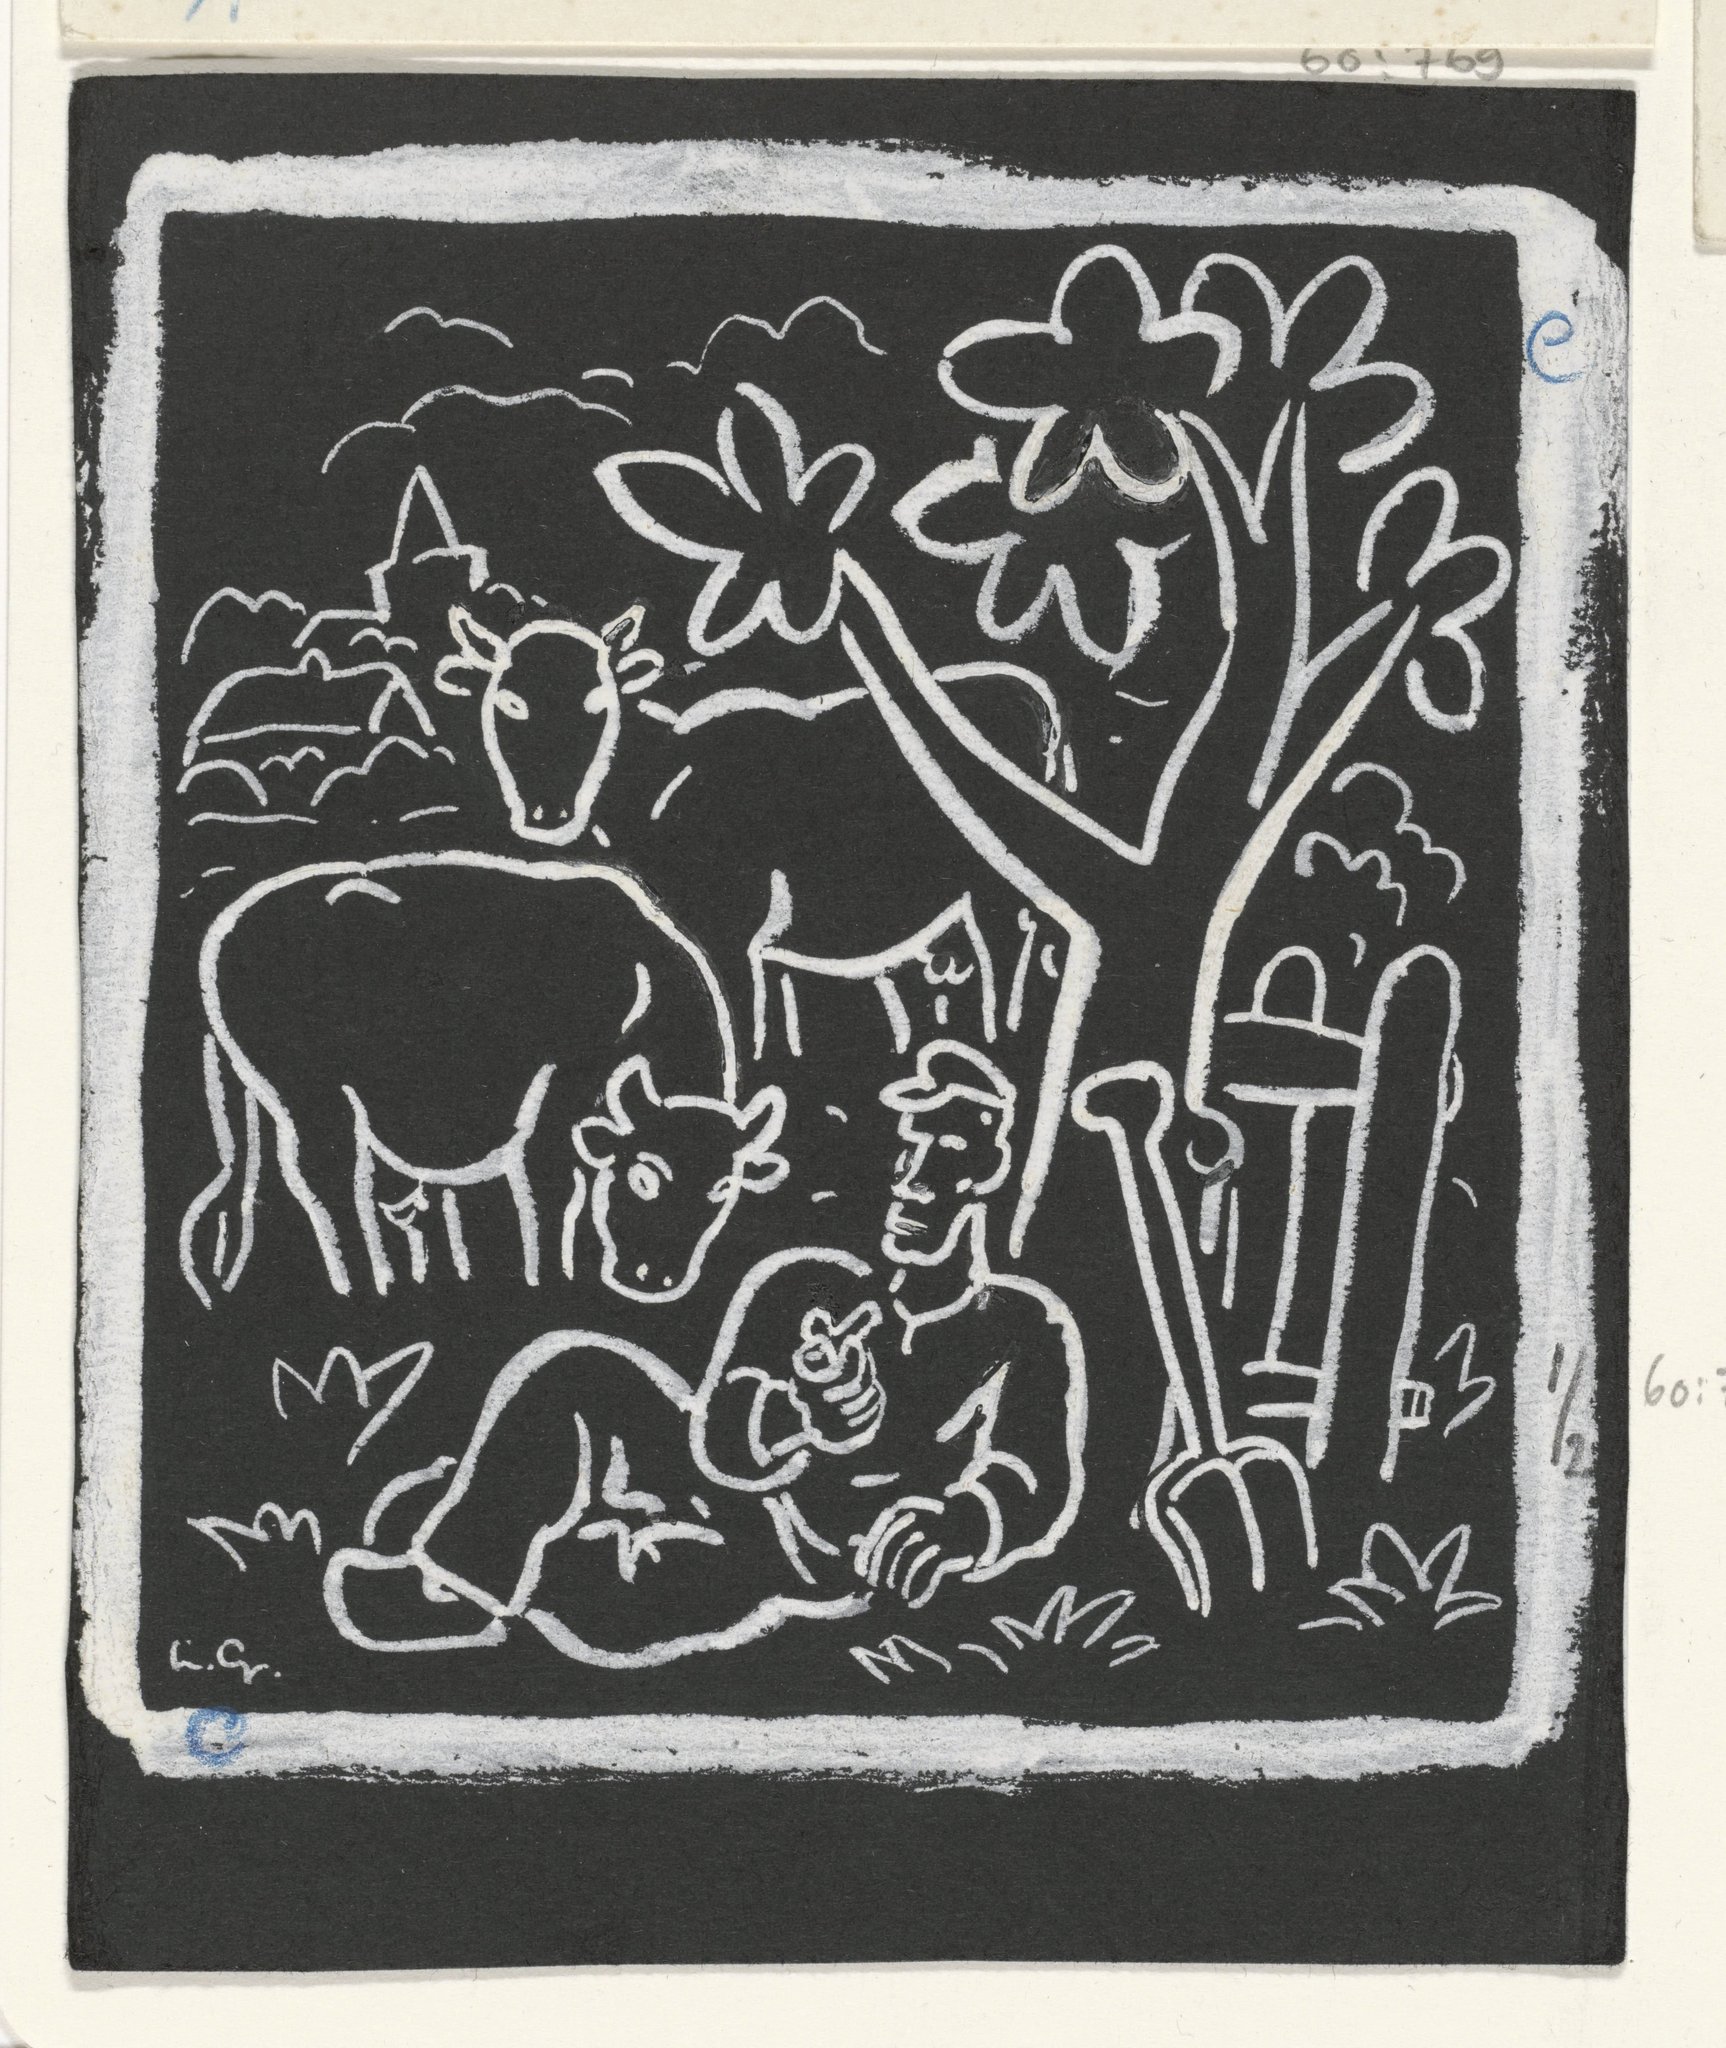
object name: design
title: Boer rustend onder een boom in een weiland met koeien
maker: leo gestel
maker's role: draughtsman, print maker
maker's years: 1881-1941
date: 1891-1941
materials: paint, paper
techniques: brush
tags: meadow, pasture, farmers